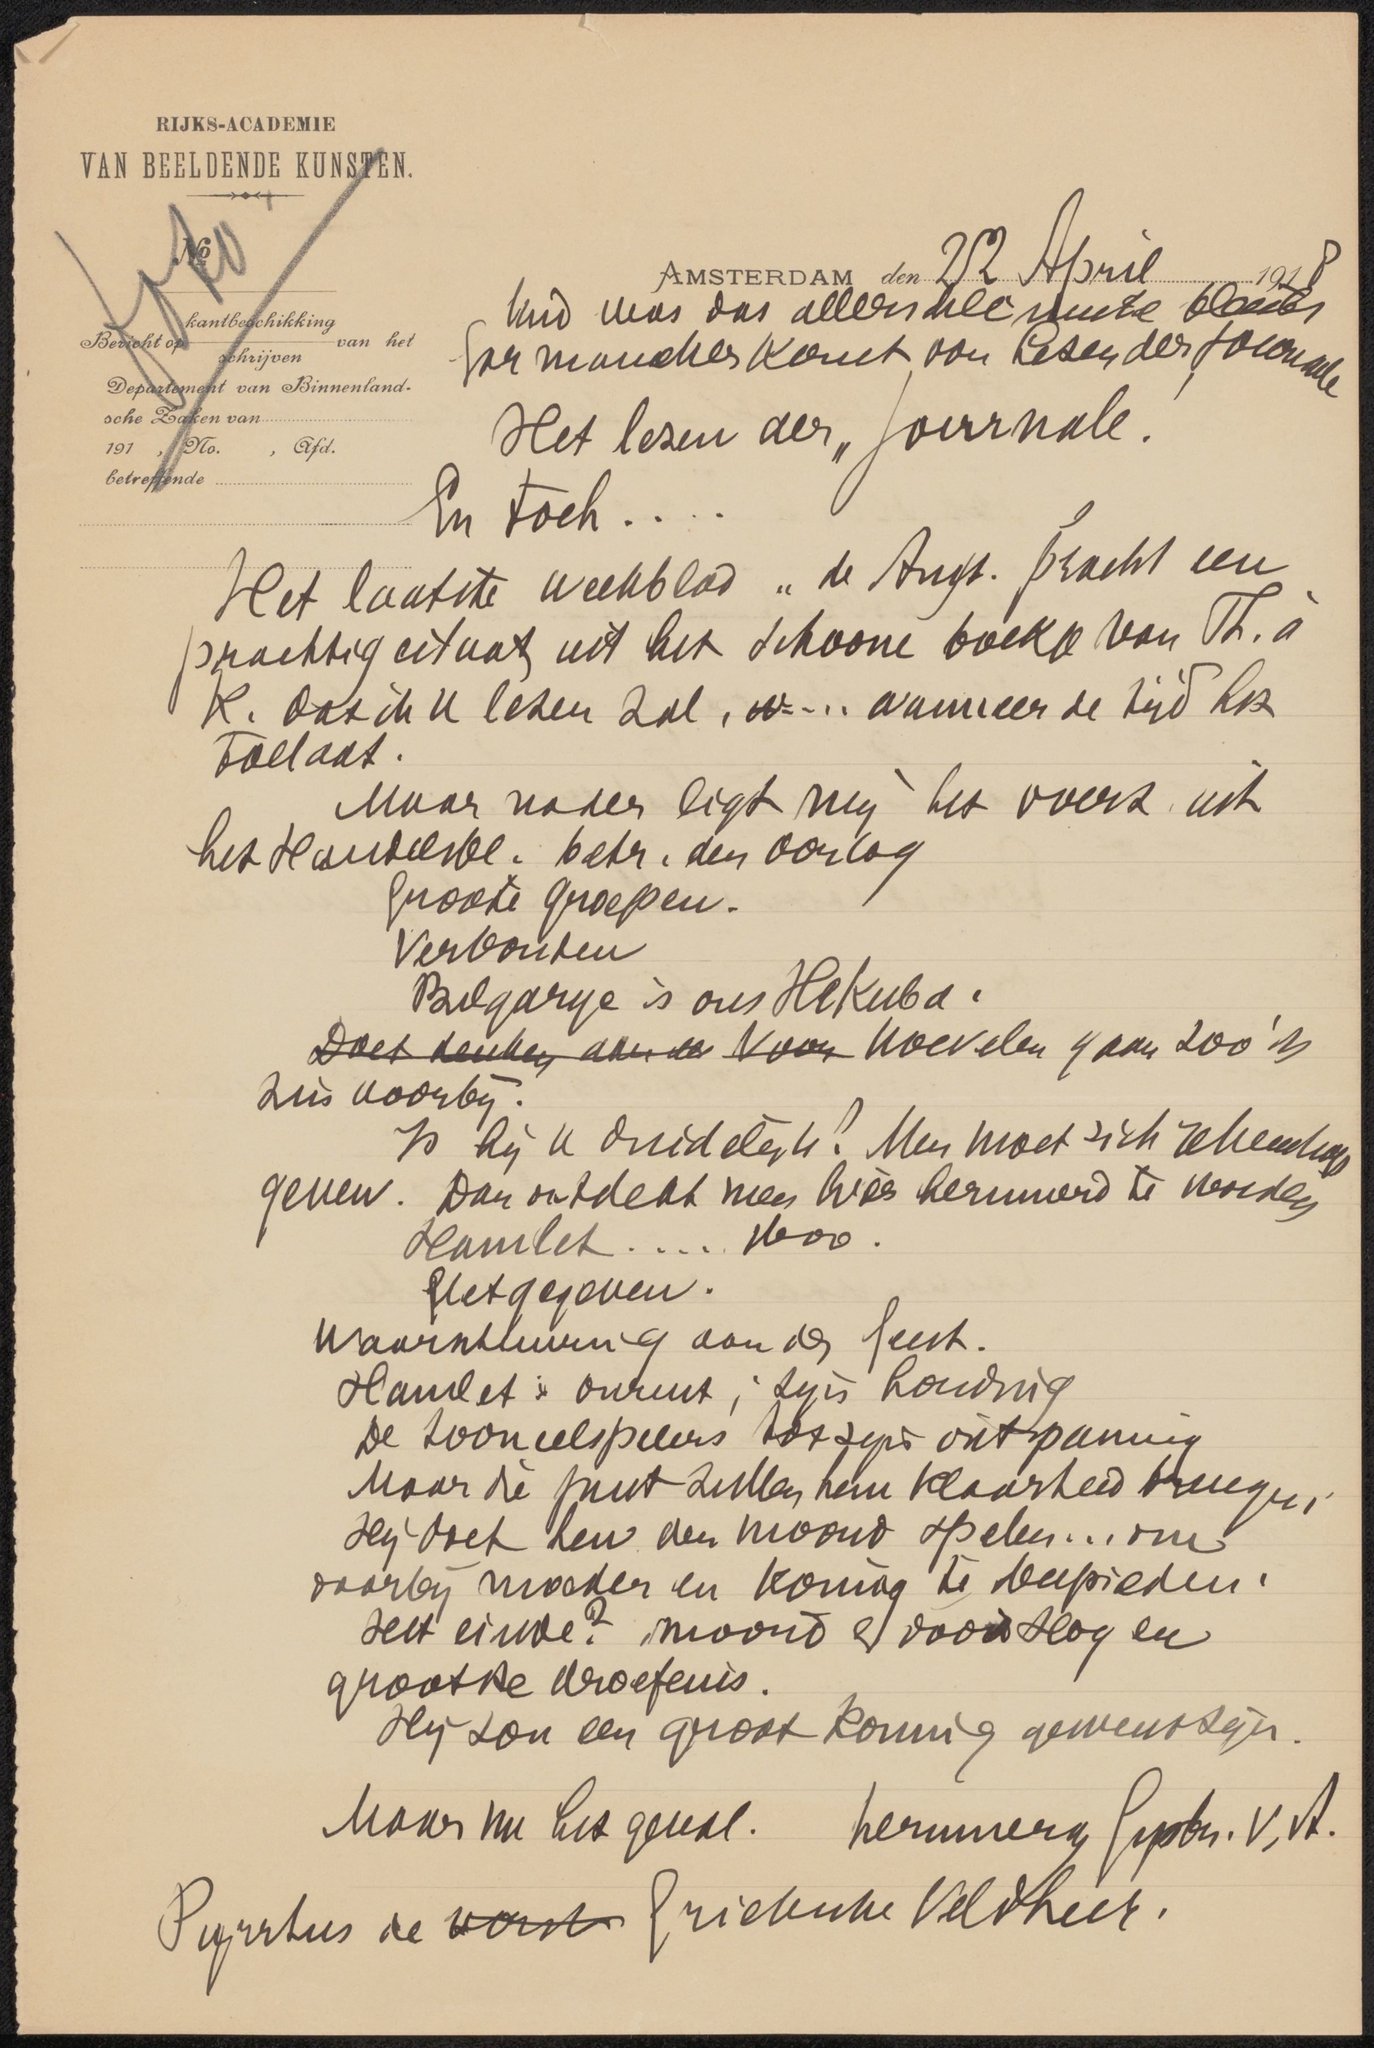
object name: aantekening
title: Aantekening uit collectie August Allebé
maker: Anonymous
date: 1918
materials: ink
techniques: pen, printing, writing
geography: amsterdam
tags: rijksakademie van beeldende kunsten